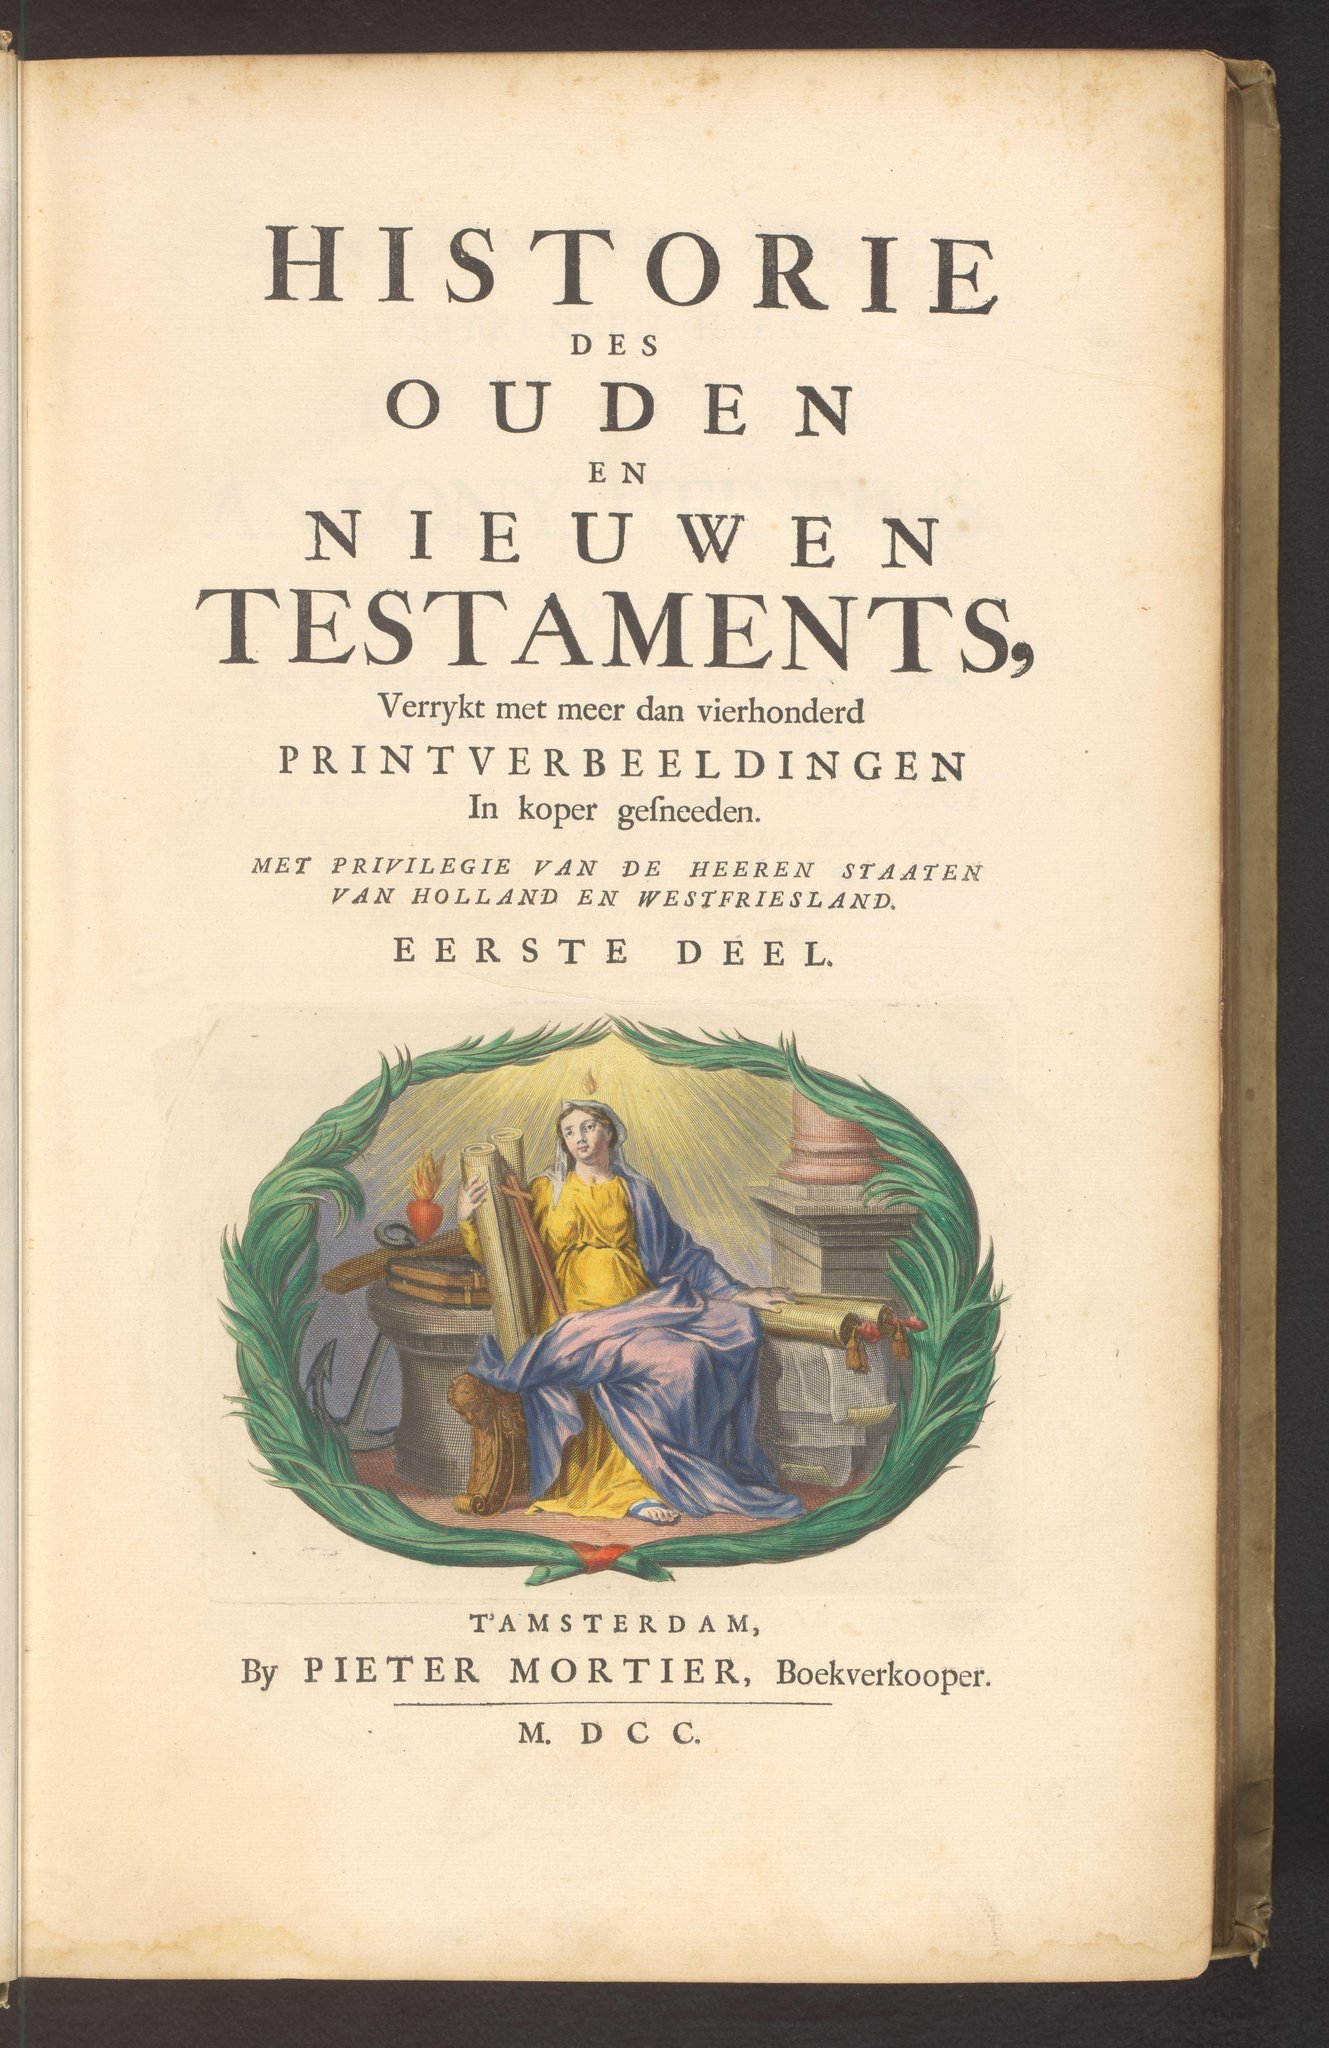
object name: titelblad, titelpagina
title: Old Testament Title Sheet in: Historie des Ouden en Nieuwen Testaments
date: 1700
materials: paint, paper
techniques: brush, engraving, hand coloring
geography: amsterdam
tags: faith, 'fides'; 'fede', 'fede catholica', 'fede christiana', 'fede christiana catholica' (ripa) ~ one of the three theological virtues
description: The so-called Mortier Bible contains 429 illustrations of the Old and New Testament. More than twenty designers and engravers were involved in the massive project. This copy contains more than 100 additional prints, including proofs and hand-coloured prints by master colourist Dirk Jansz van Santen. The gold stamped bindings were used exclusively for deluxe editions by the Amsterdam publisher Pieter Mortier.